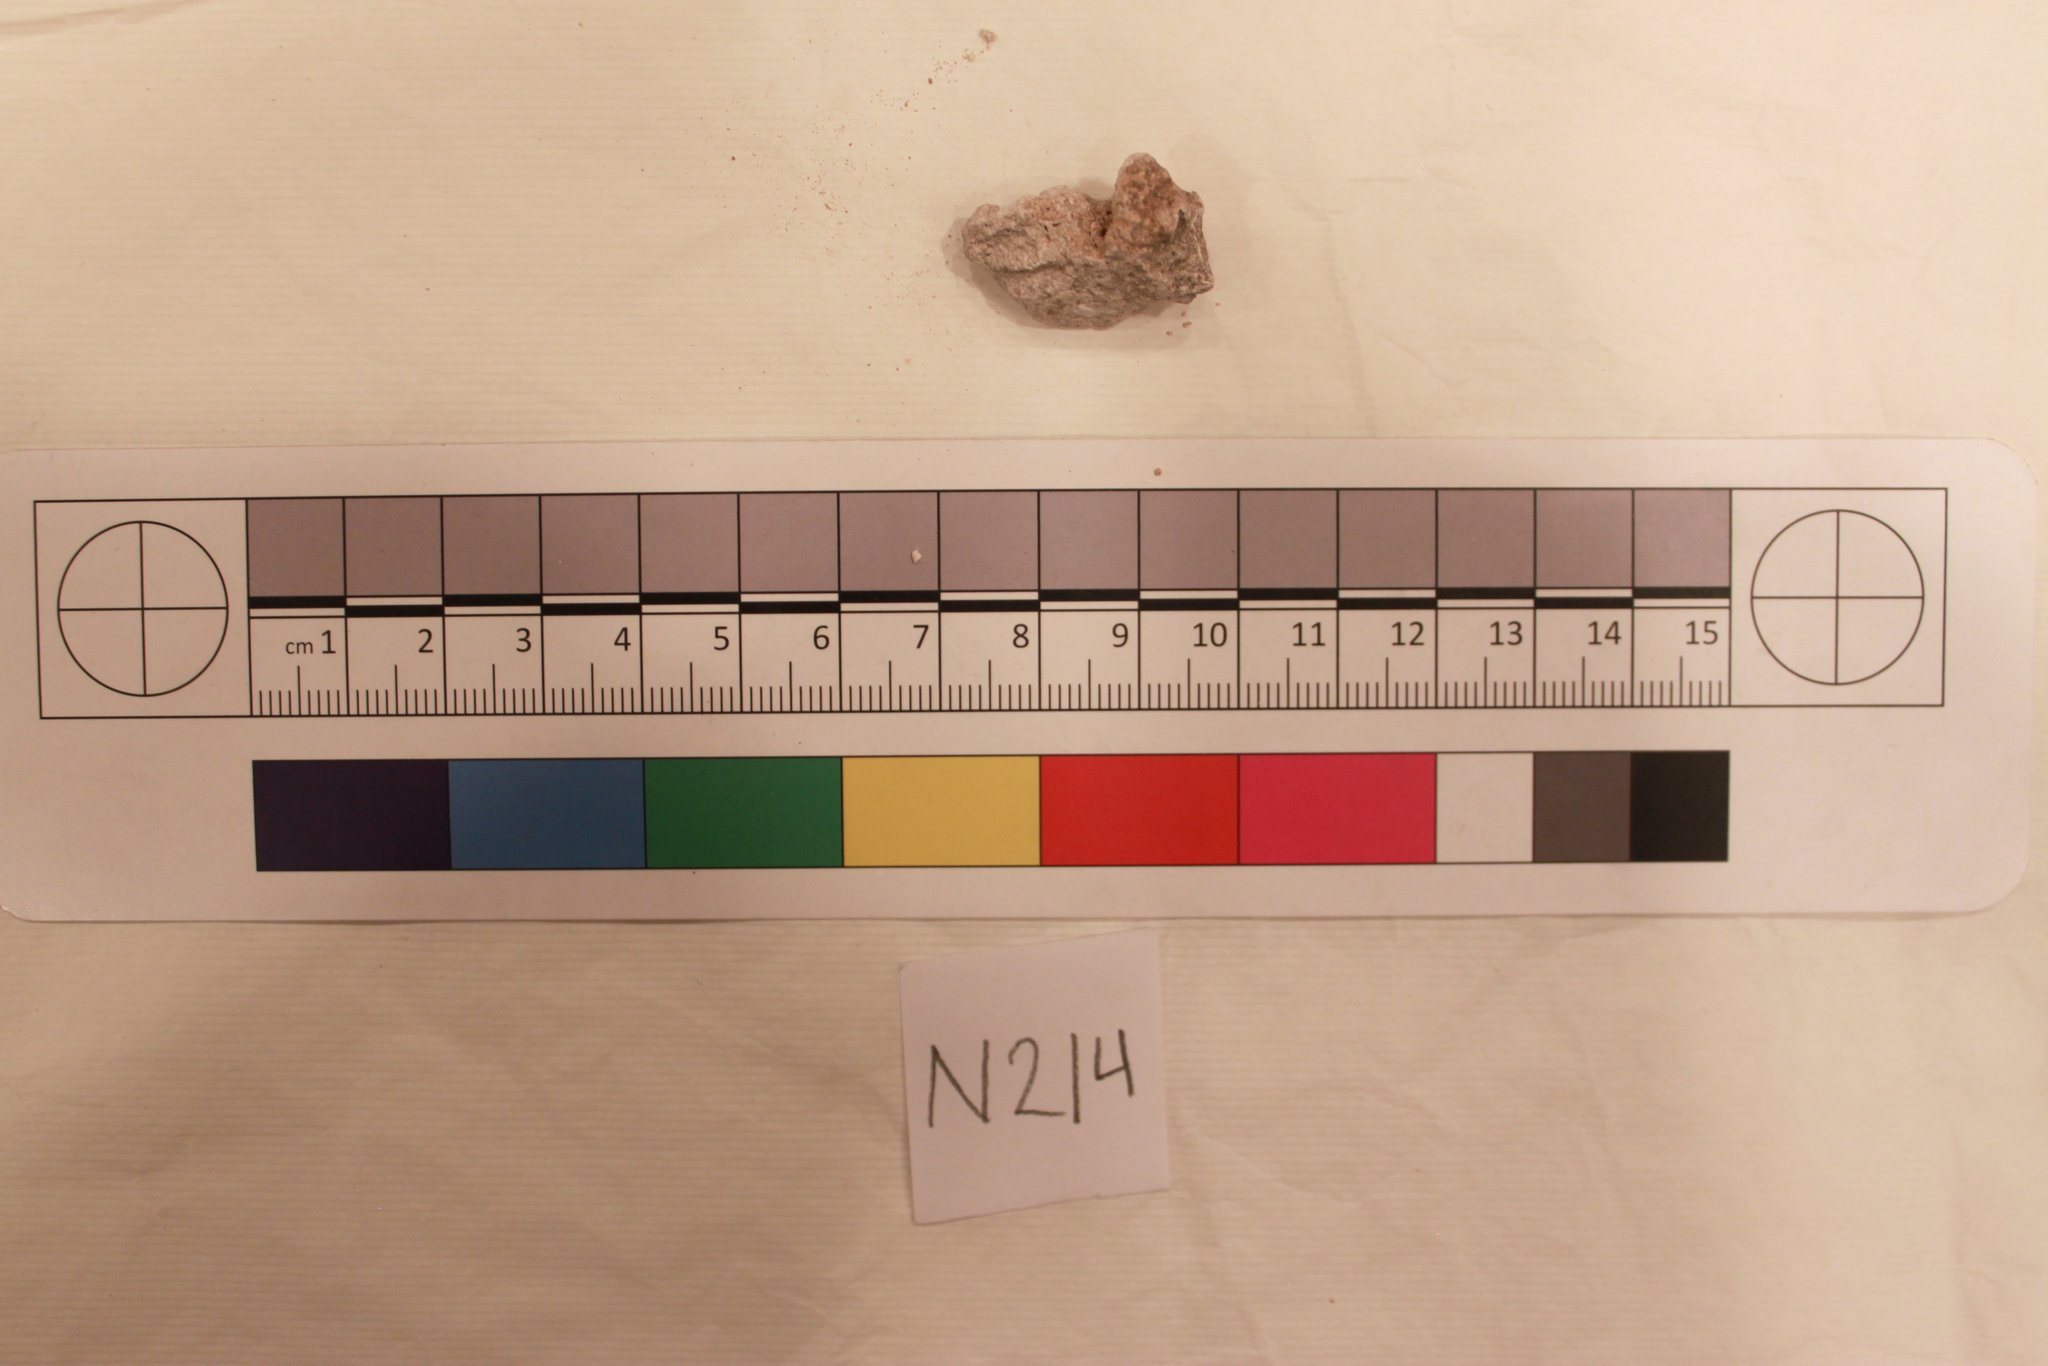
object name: fragment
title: Stucco Fragment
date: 701-1200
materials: plaster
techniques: carving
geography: iran